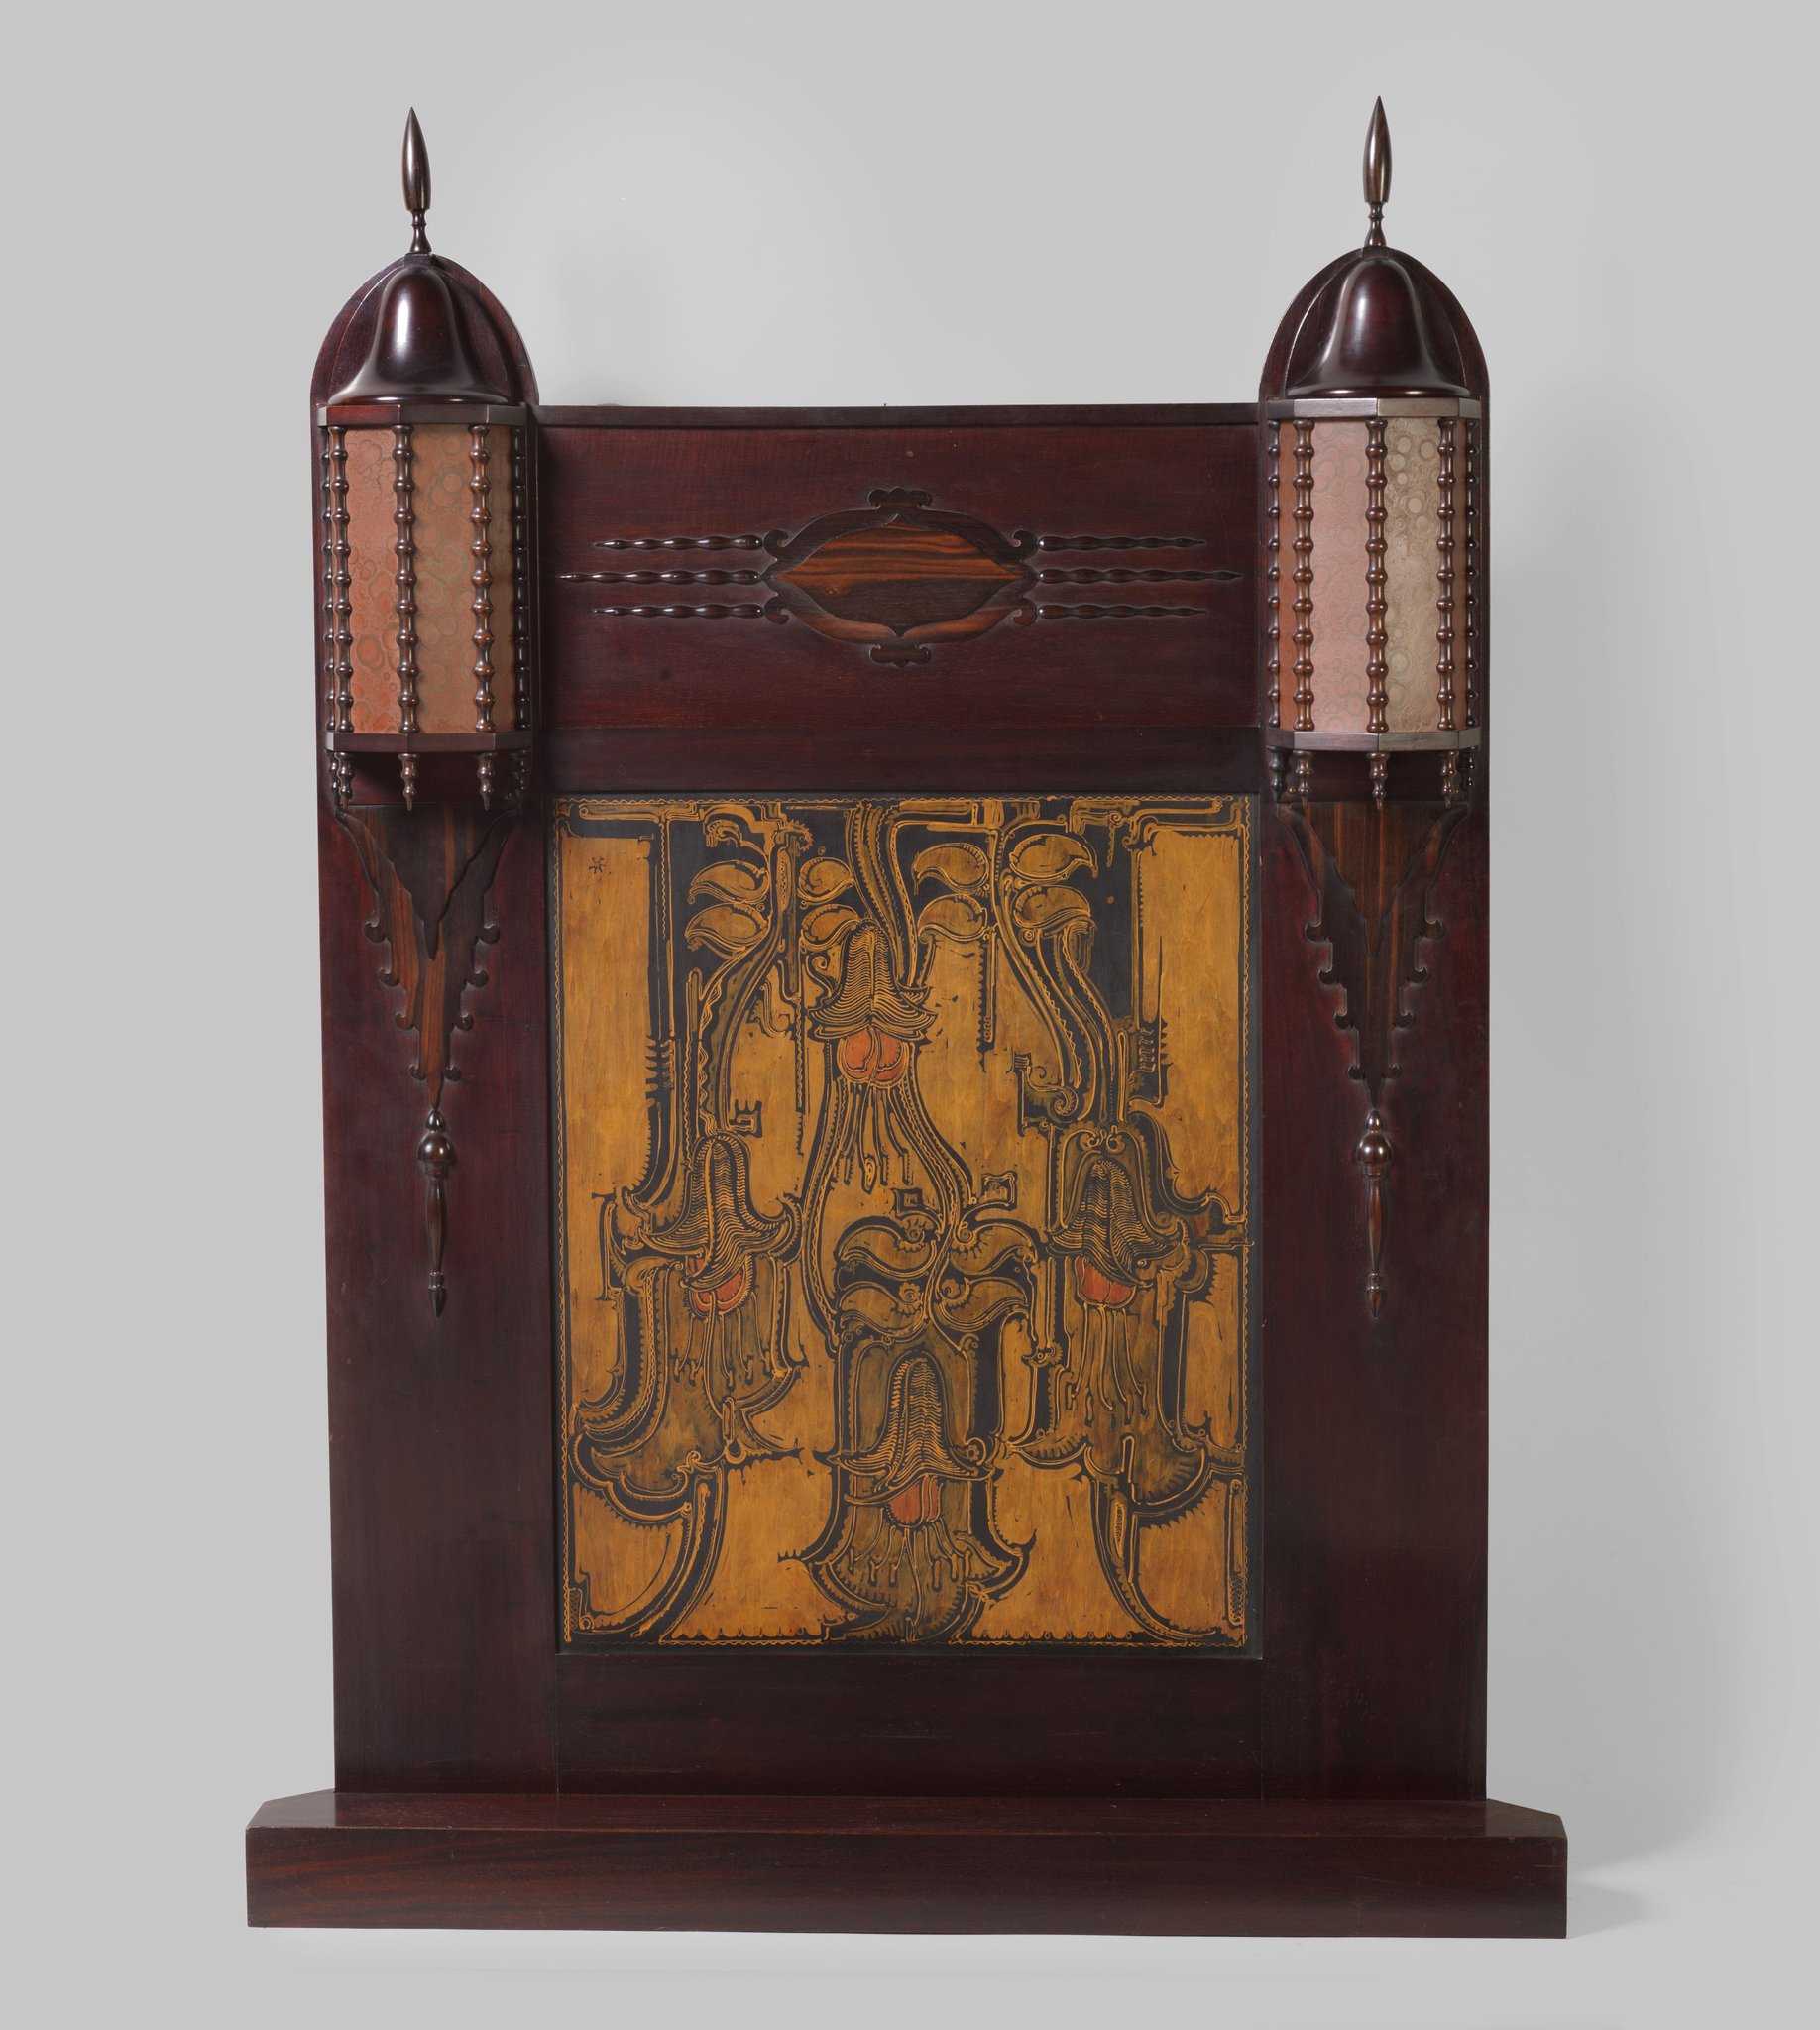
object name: architectural element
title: Schoorsteenboezem bestaande uit een raamwerk met twee lichtornamenten om een houten gebatikt paneel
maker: Anonymous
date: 1925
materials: wood, glass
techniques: batik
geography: northern netherlands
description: Schoorsteenboezem bestaande uit een raamwerk van coromandelhout met twee lichtornamenten om een houten gebatikt paneel, dat in zwart, rood en groen gestileerde bloemkelken en bladwerk toont. De uitstekende basis heeft afgeschuinde achterhoeken. De half lantaarnvormige lichtornamenten links en rechts boven hebben een klokvormige bekroning met hoge gedraaide punt en donkerbruin gemarmerd gebrand glas met stijlen met draaiwerk, die onderaan doorlopen. Op de stijlen en bovendorpel druipers en andere ornamenten.